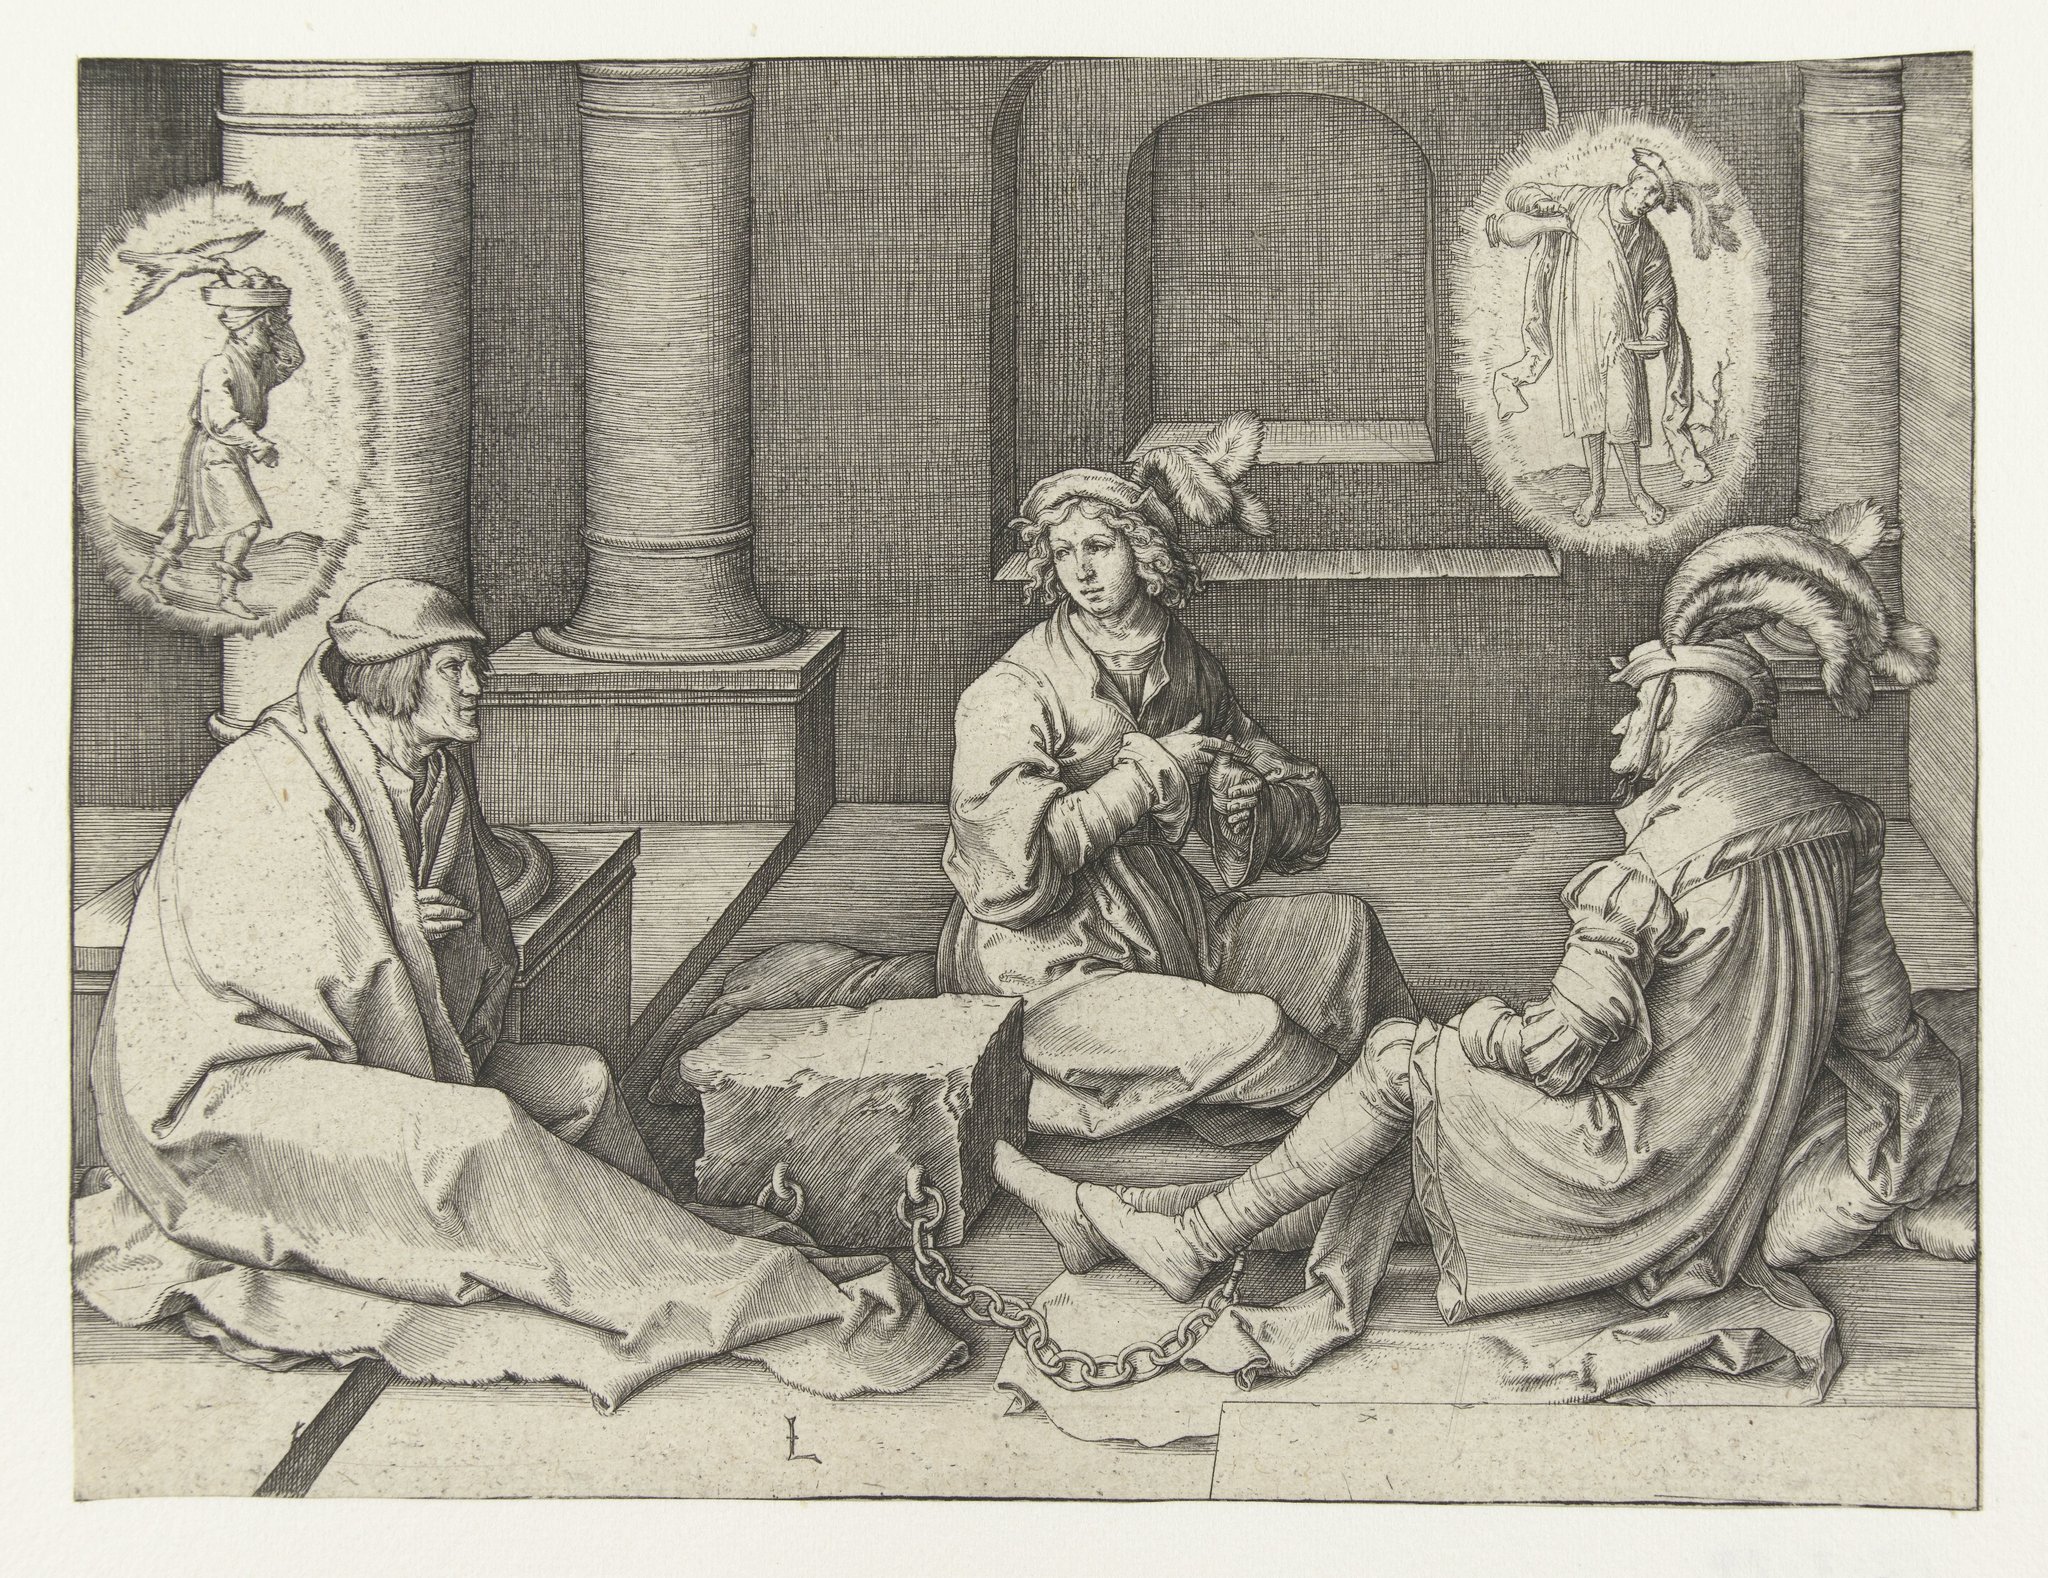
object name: print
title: Jozef verklaart dromen in de gevangenis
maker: lucas van leyden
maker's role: draughtsman, painter, print maker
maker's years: 1494-1533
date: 1512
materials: paper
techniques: engraving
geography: leiden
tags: joseph interpreting the dreams of the butler and the baker (the two dreams combined)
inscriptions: collector's mark: Lugt 240, signature and date: ‘L 1512’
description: Jozef gezeten tussen twee andere gevangenen. Boven hoofden van gevangenen ovaal met afbeelding van droom.